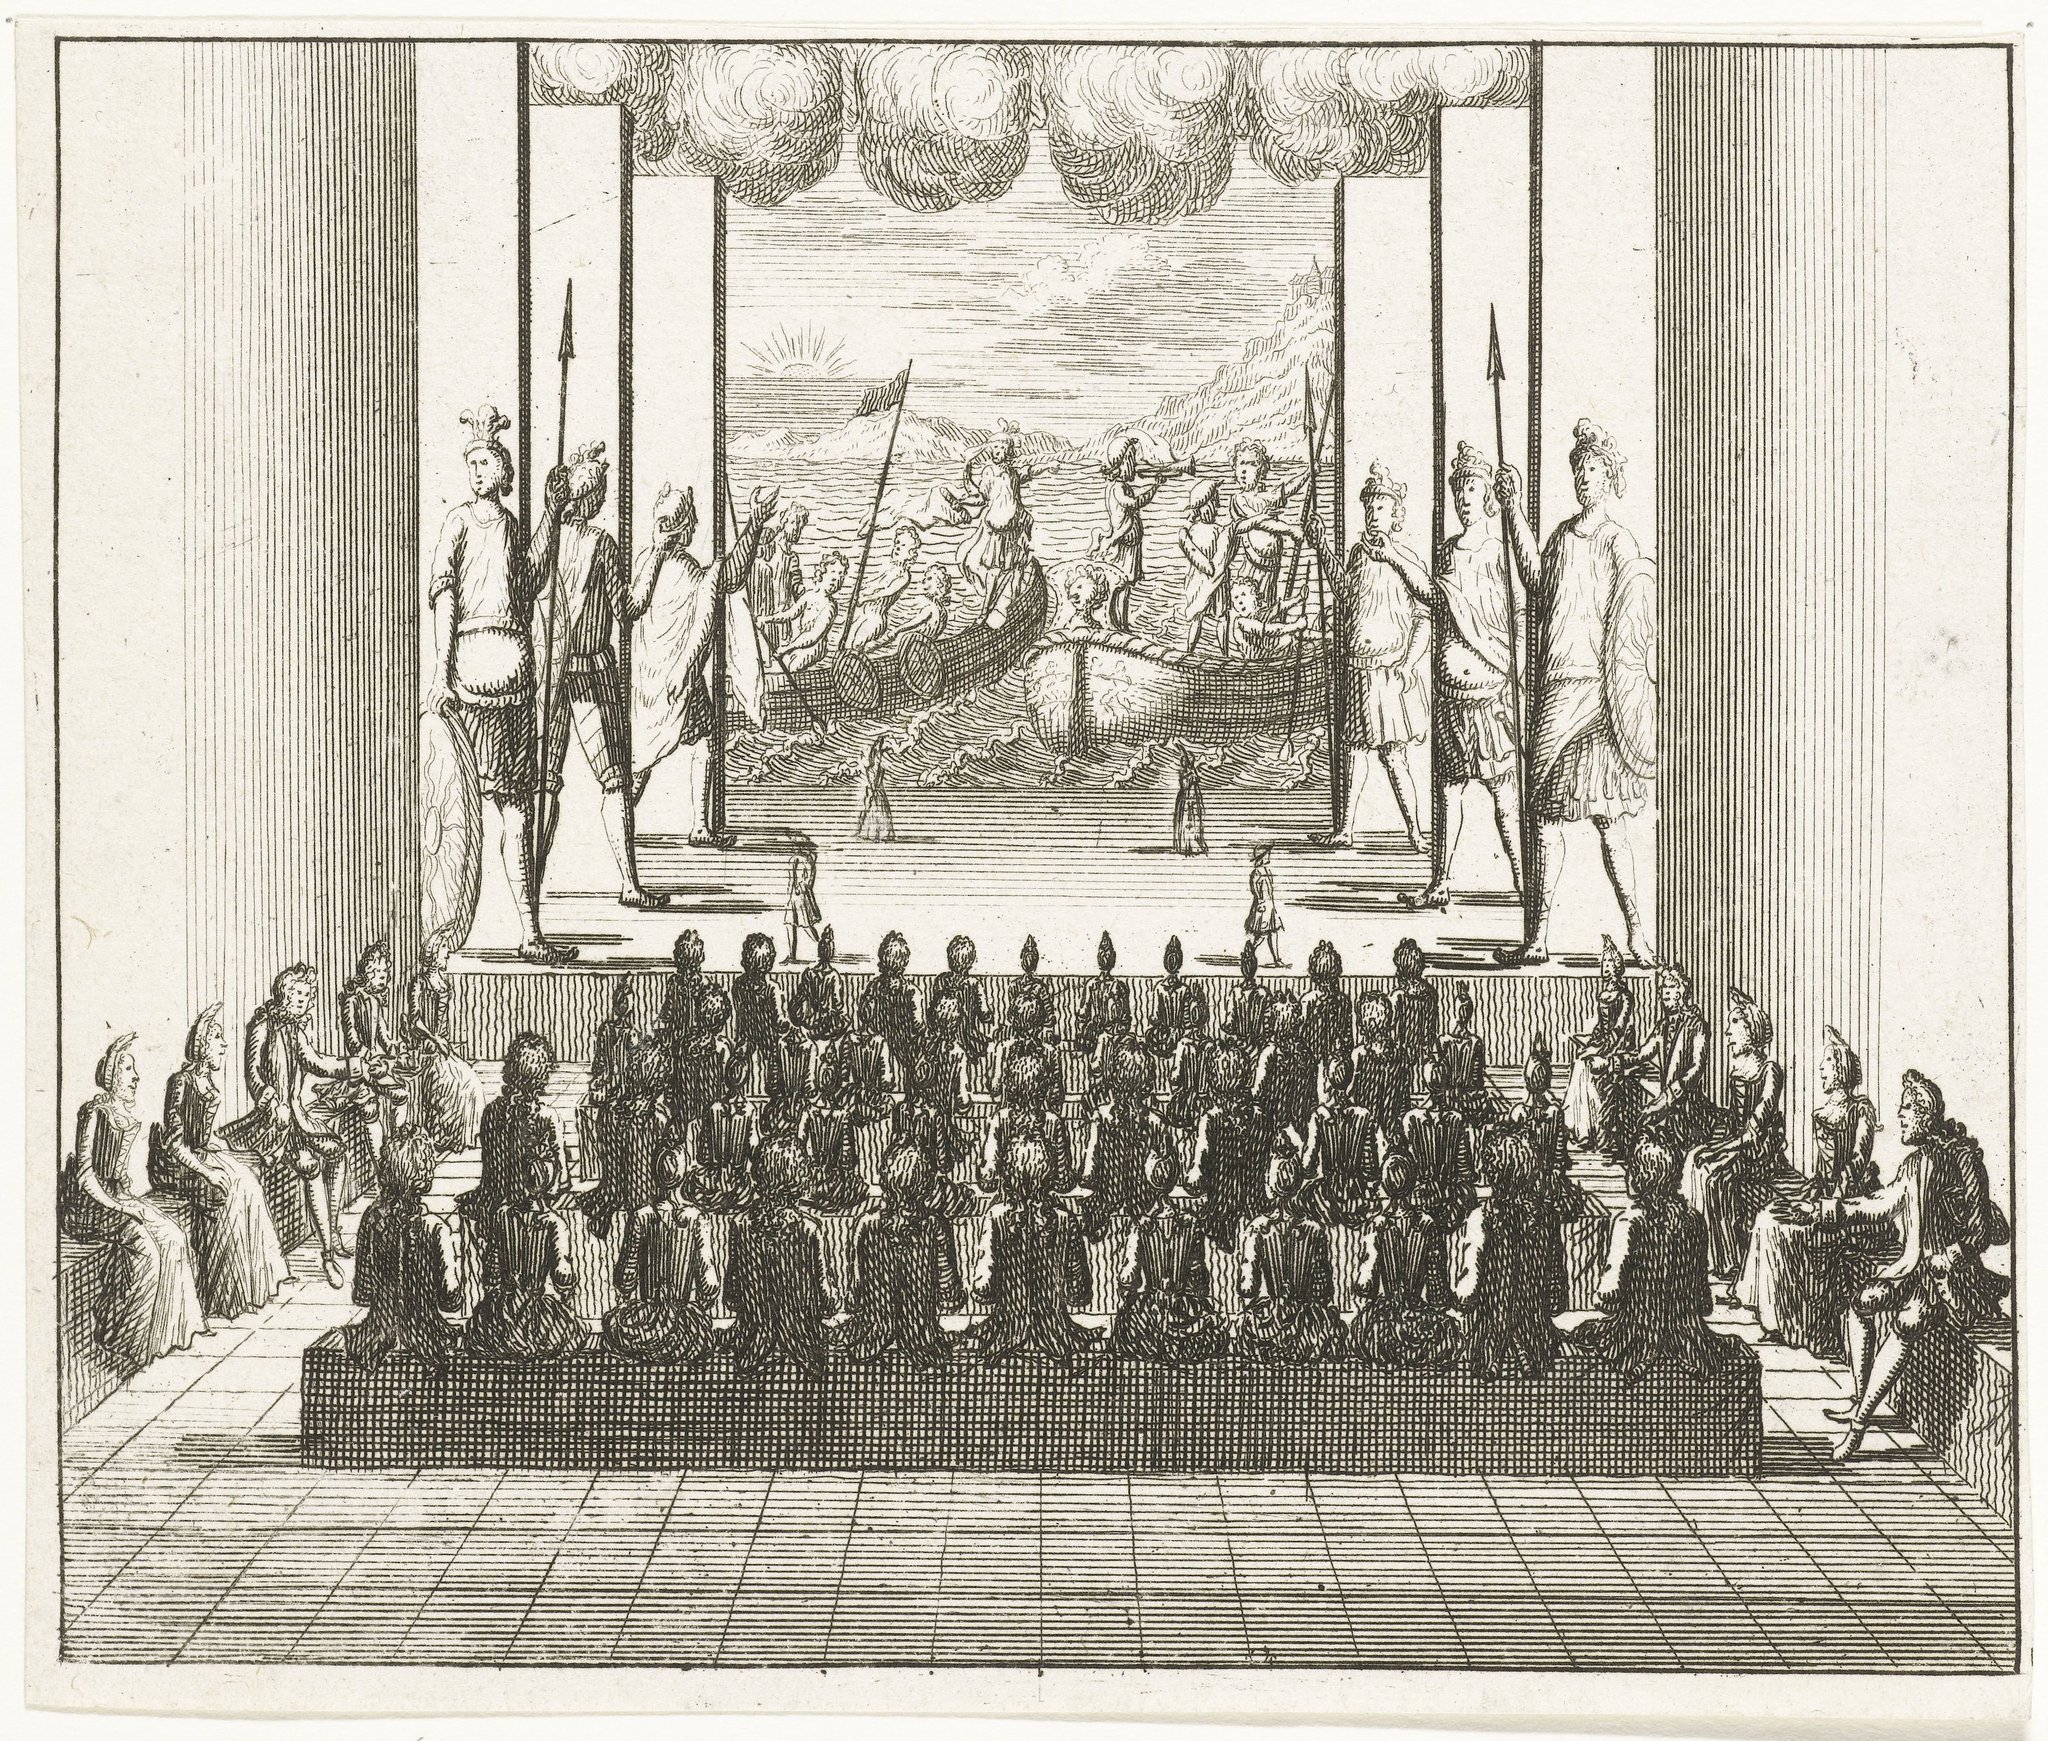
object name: print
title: Toneelvoorstelling in een zaal, 1714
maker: Anonymous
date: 1714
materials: paper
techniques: etching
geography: northern netherlands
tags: vienna, public festivities at birth of royal persons, theatre, theatrical performance, utrecht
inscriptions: collector's mark: Lugt 2228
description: Toneelvoorstelling in een zaal, 1714. Onderdeel van een groep van twaalf illustraties van de feestelijkheden georganiseerd in Utrecht in 1714 door de Portugese graaf Joao Gomes da Silva conde de Tarouca ter ere van de geboorte van twee Portugese prinsjes van koning Johan V.